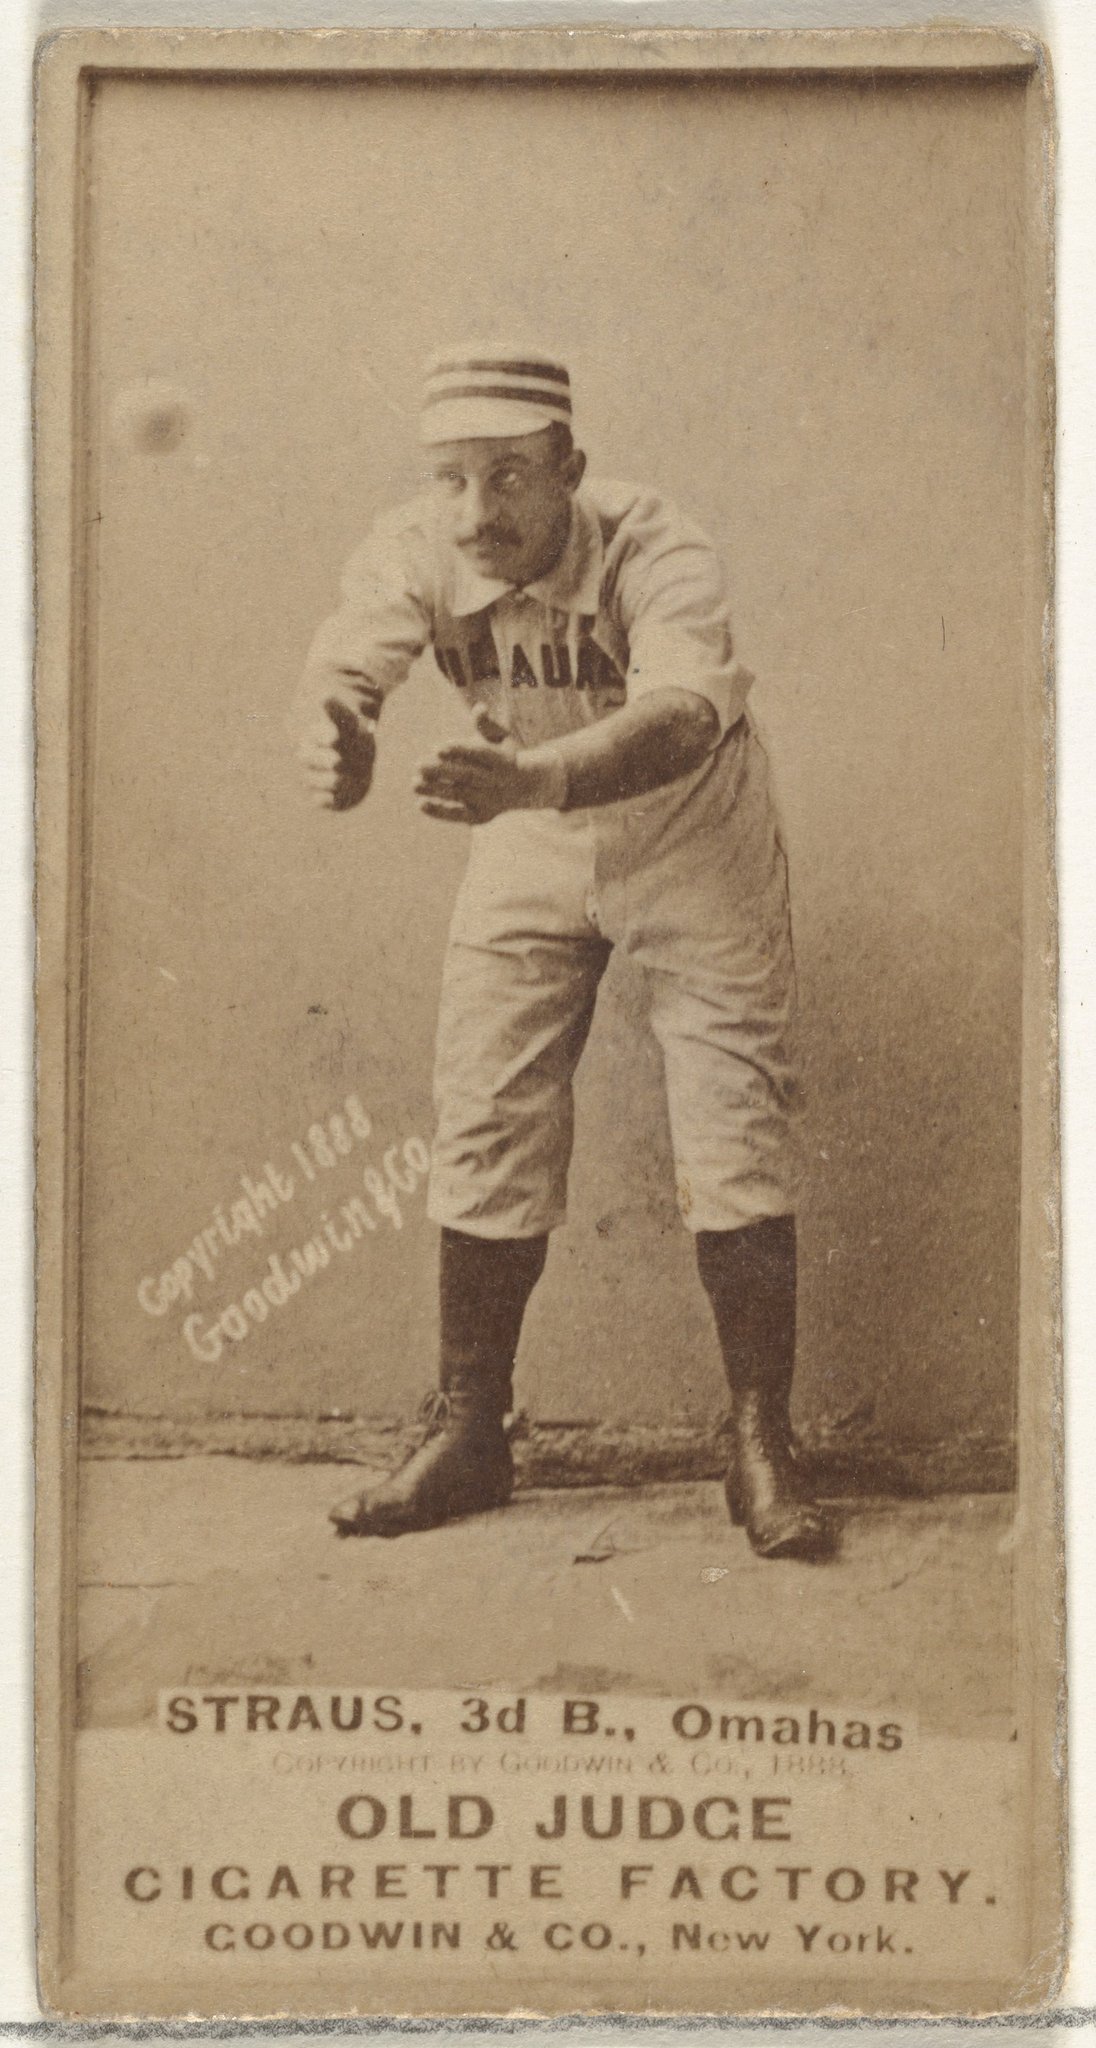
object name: baseball card, photograph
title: Joseph "Joe" Strauss, 3rd Base, Omaha Omahogs/ Lambs, from the Old Judge series (N172) for Old Judge Cigarettes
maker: goodwin & company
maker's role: publisher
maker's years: 1850-1950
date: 1888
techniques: albumen silver print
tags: men,portraits,baseball,athletes